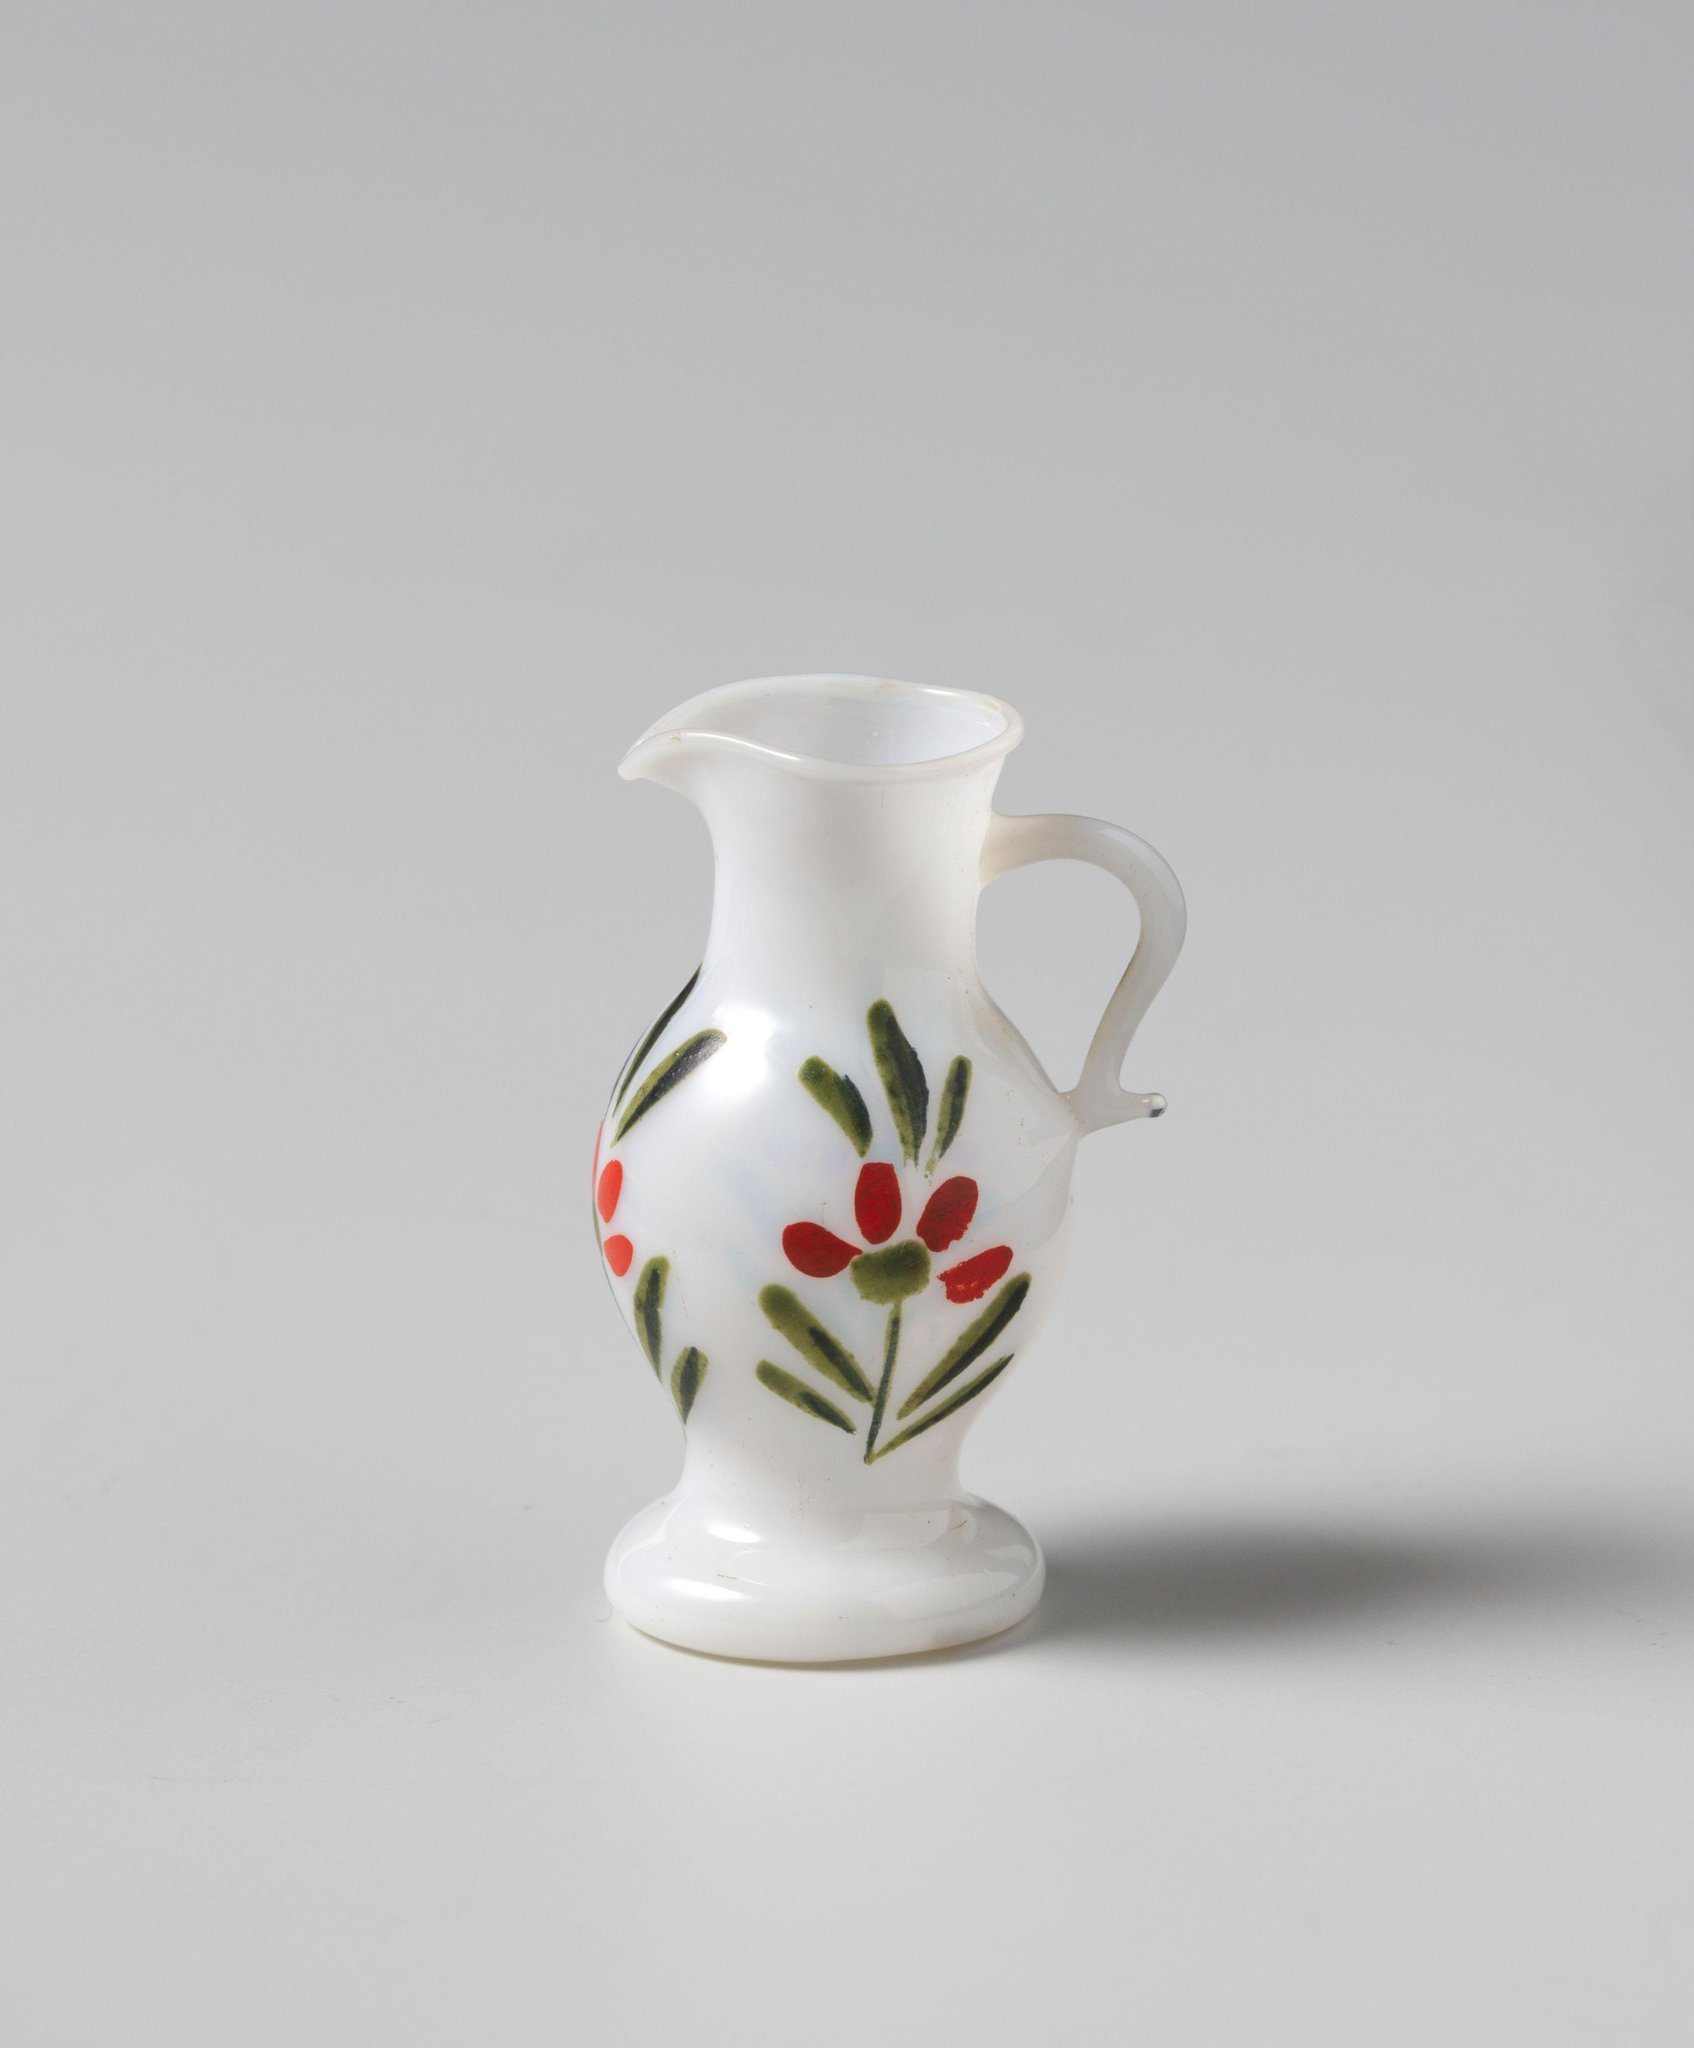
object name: miniature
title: Kan, beschilderd met bloem in groen en rood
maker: Anonymous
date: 1800-1849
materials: glass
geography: bristol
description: Kan van opaak wit glas, de buik overgaand in verbredende voet, en hals met tuit. De kan heeft een s-vormig oor. De buik beschilderd met bloem in groen en rood.